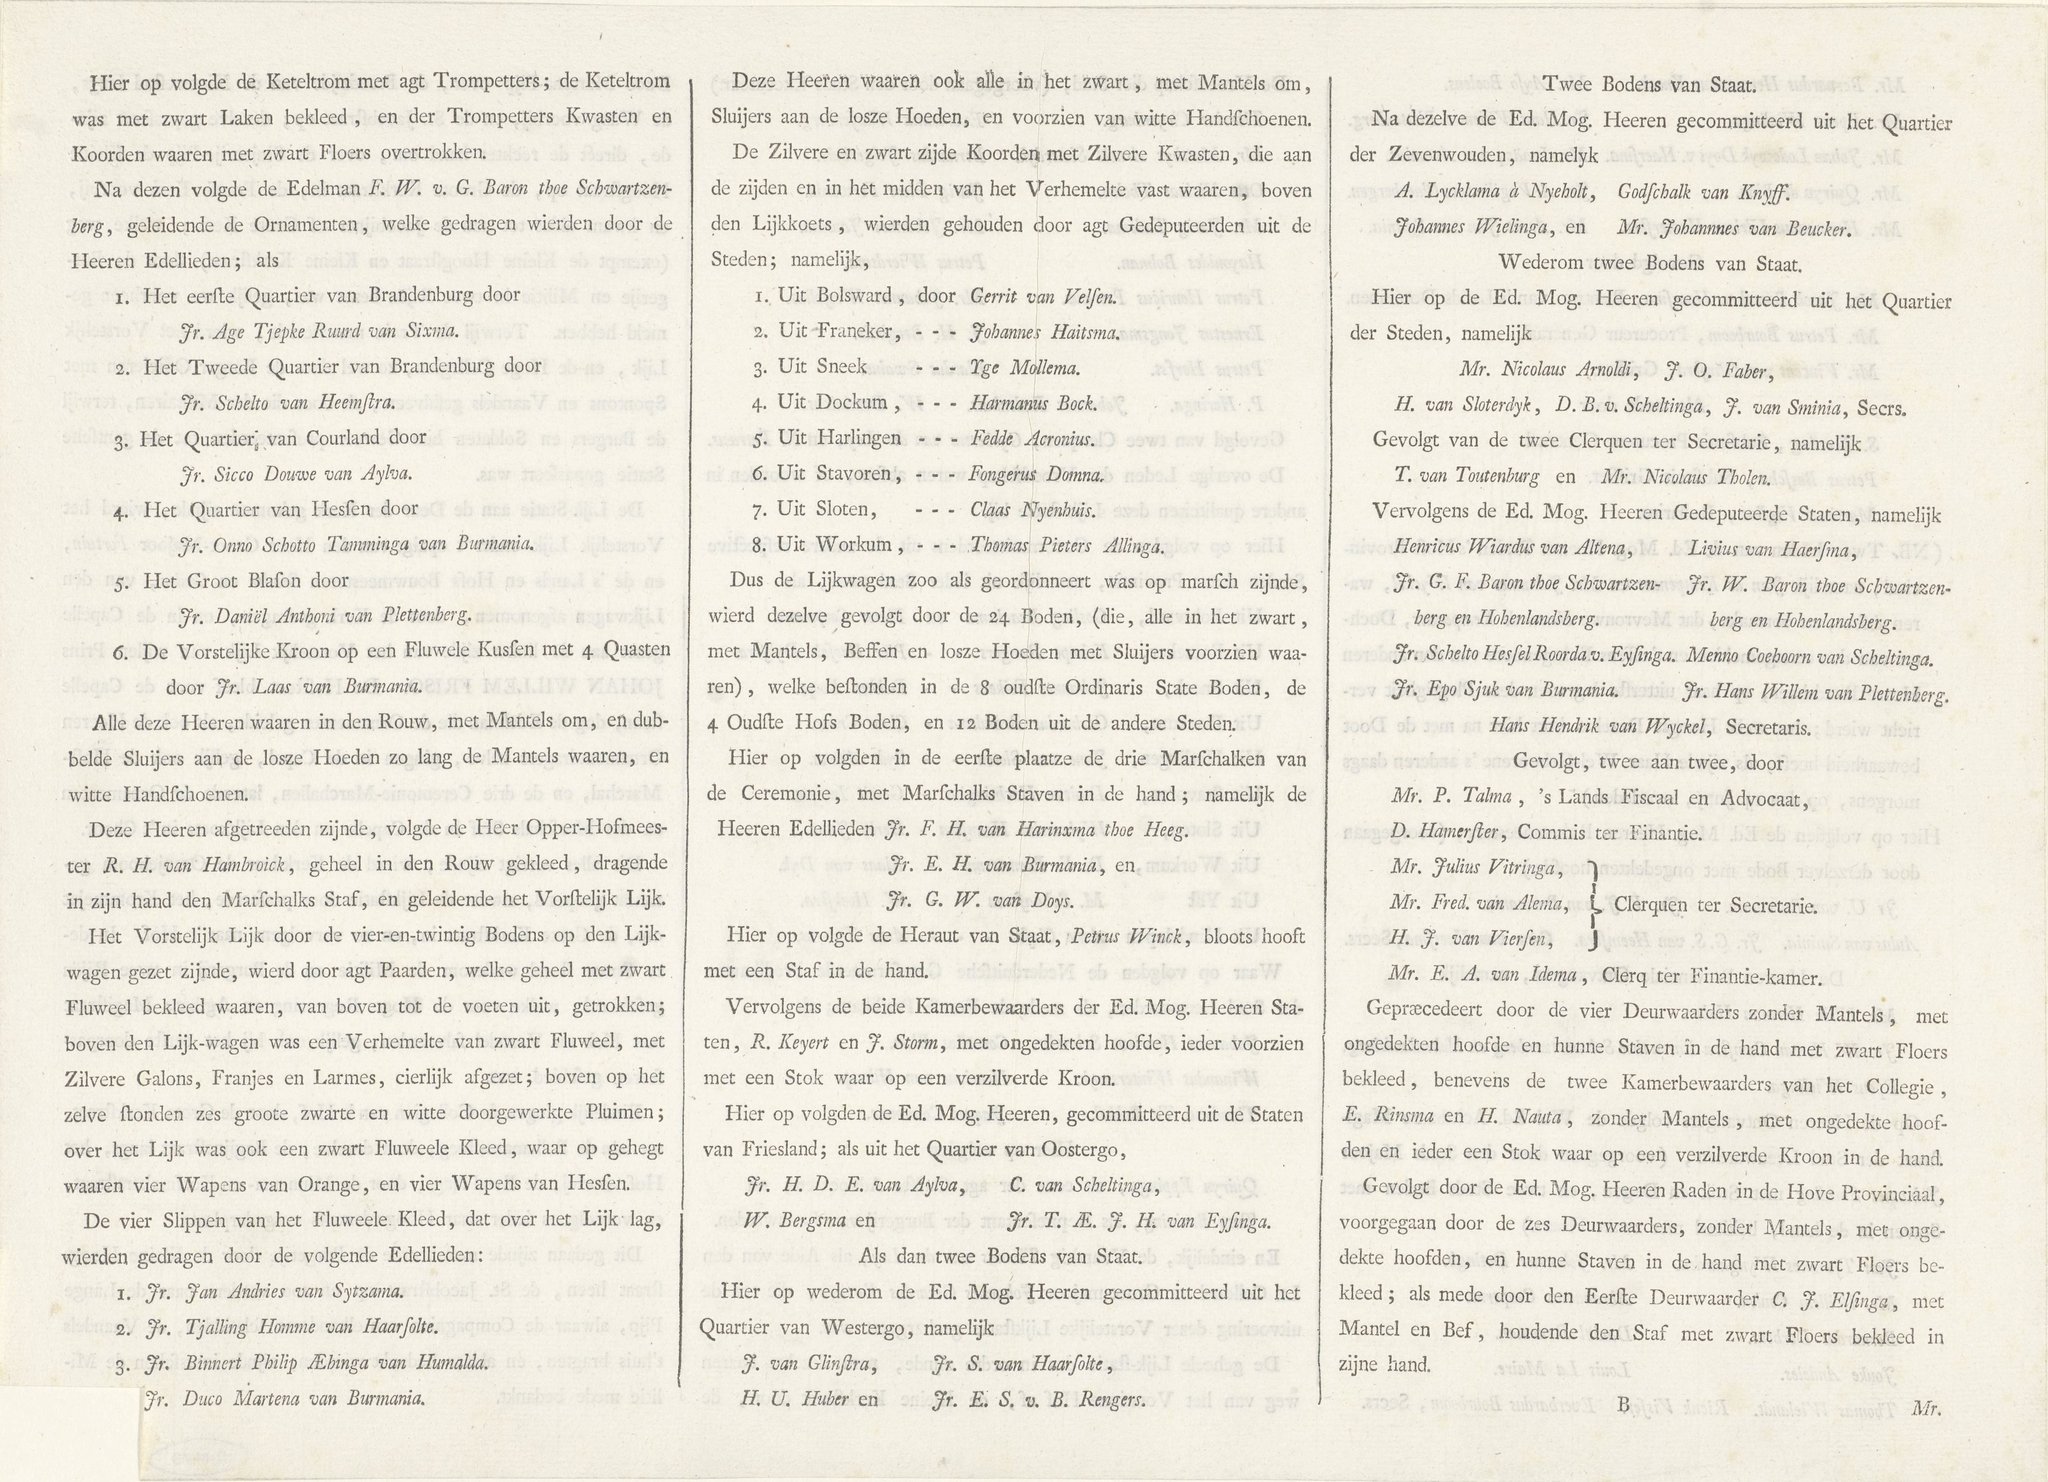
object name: text sheet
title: Lijkstatie van prinses Maria Louise, 1765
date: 1765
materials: paper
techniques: letterpress printing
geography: leeuwarden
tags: kassel, leeuwarden, maria louisa van hessen-kassel, begrafenis van maria louise, prinses van oranje-nassau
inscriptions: date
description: Tekstblad met in drie kolommen een deel van de beschrijving van de lijkstatie. Gemerkt rechtsonder: B. Onderdeel van de serie platen van de begrafenis van prinses Maria Louise te Leeuwarden op 13 juni 1765.